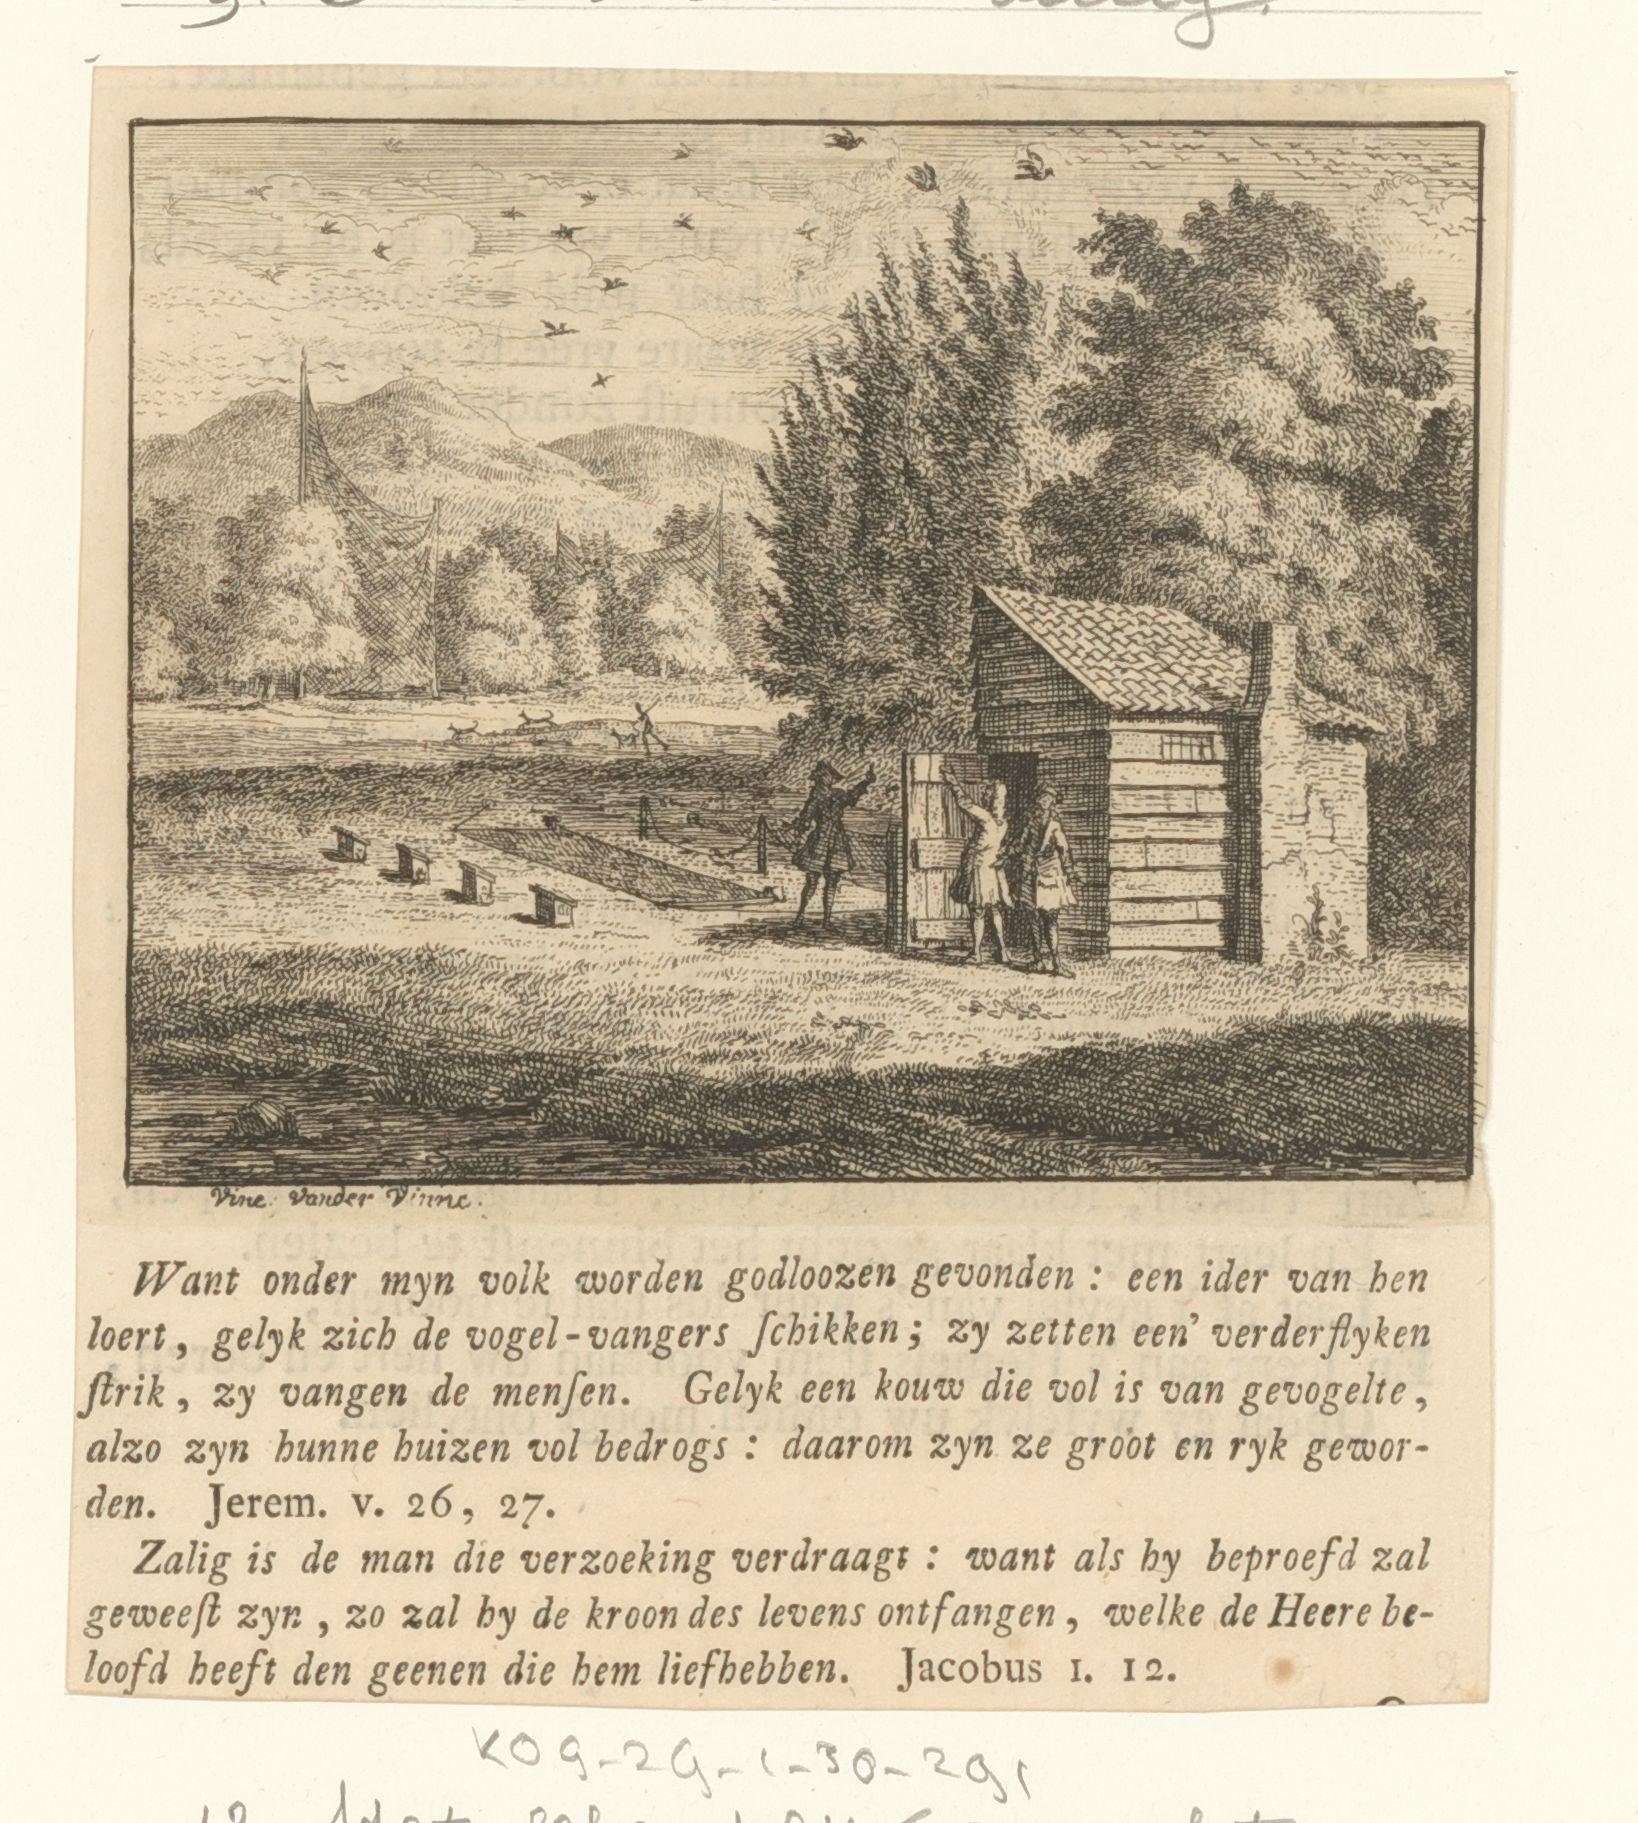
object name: print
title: Jagershut in het bos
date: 1758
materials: paper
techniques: etching, letterpress printing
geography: haarlem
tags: birds, bird hunting, proverbs, sayings, etc.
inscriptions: stamp, collector's mark: Lugt 1641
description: Embleem bij het motto: Door vluchten veilig. Onderaan een achtregelige tekst in het Nederlands. Onderwerpsrubrieken binnen de Atlas Zeden en Gewoonten: Zeden en Gewoonten in engeren zin. Volksleven. Zinnebeeldige voorstellingen uit het volkleven op serieprenten. Maanden en diversen (allegorieën).